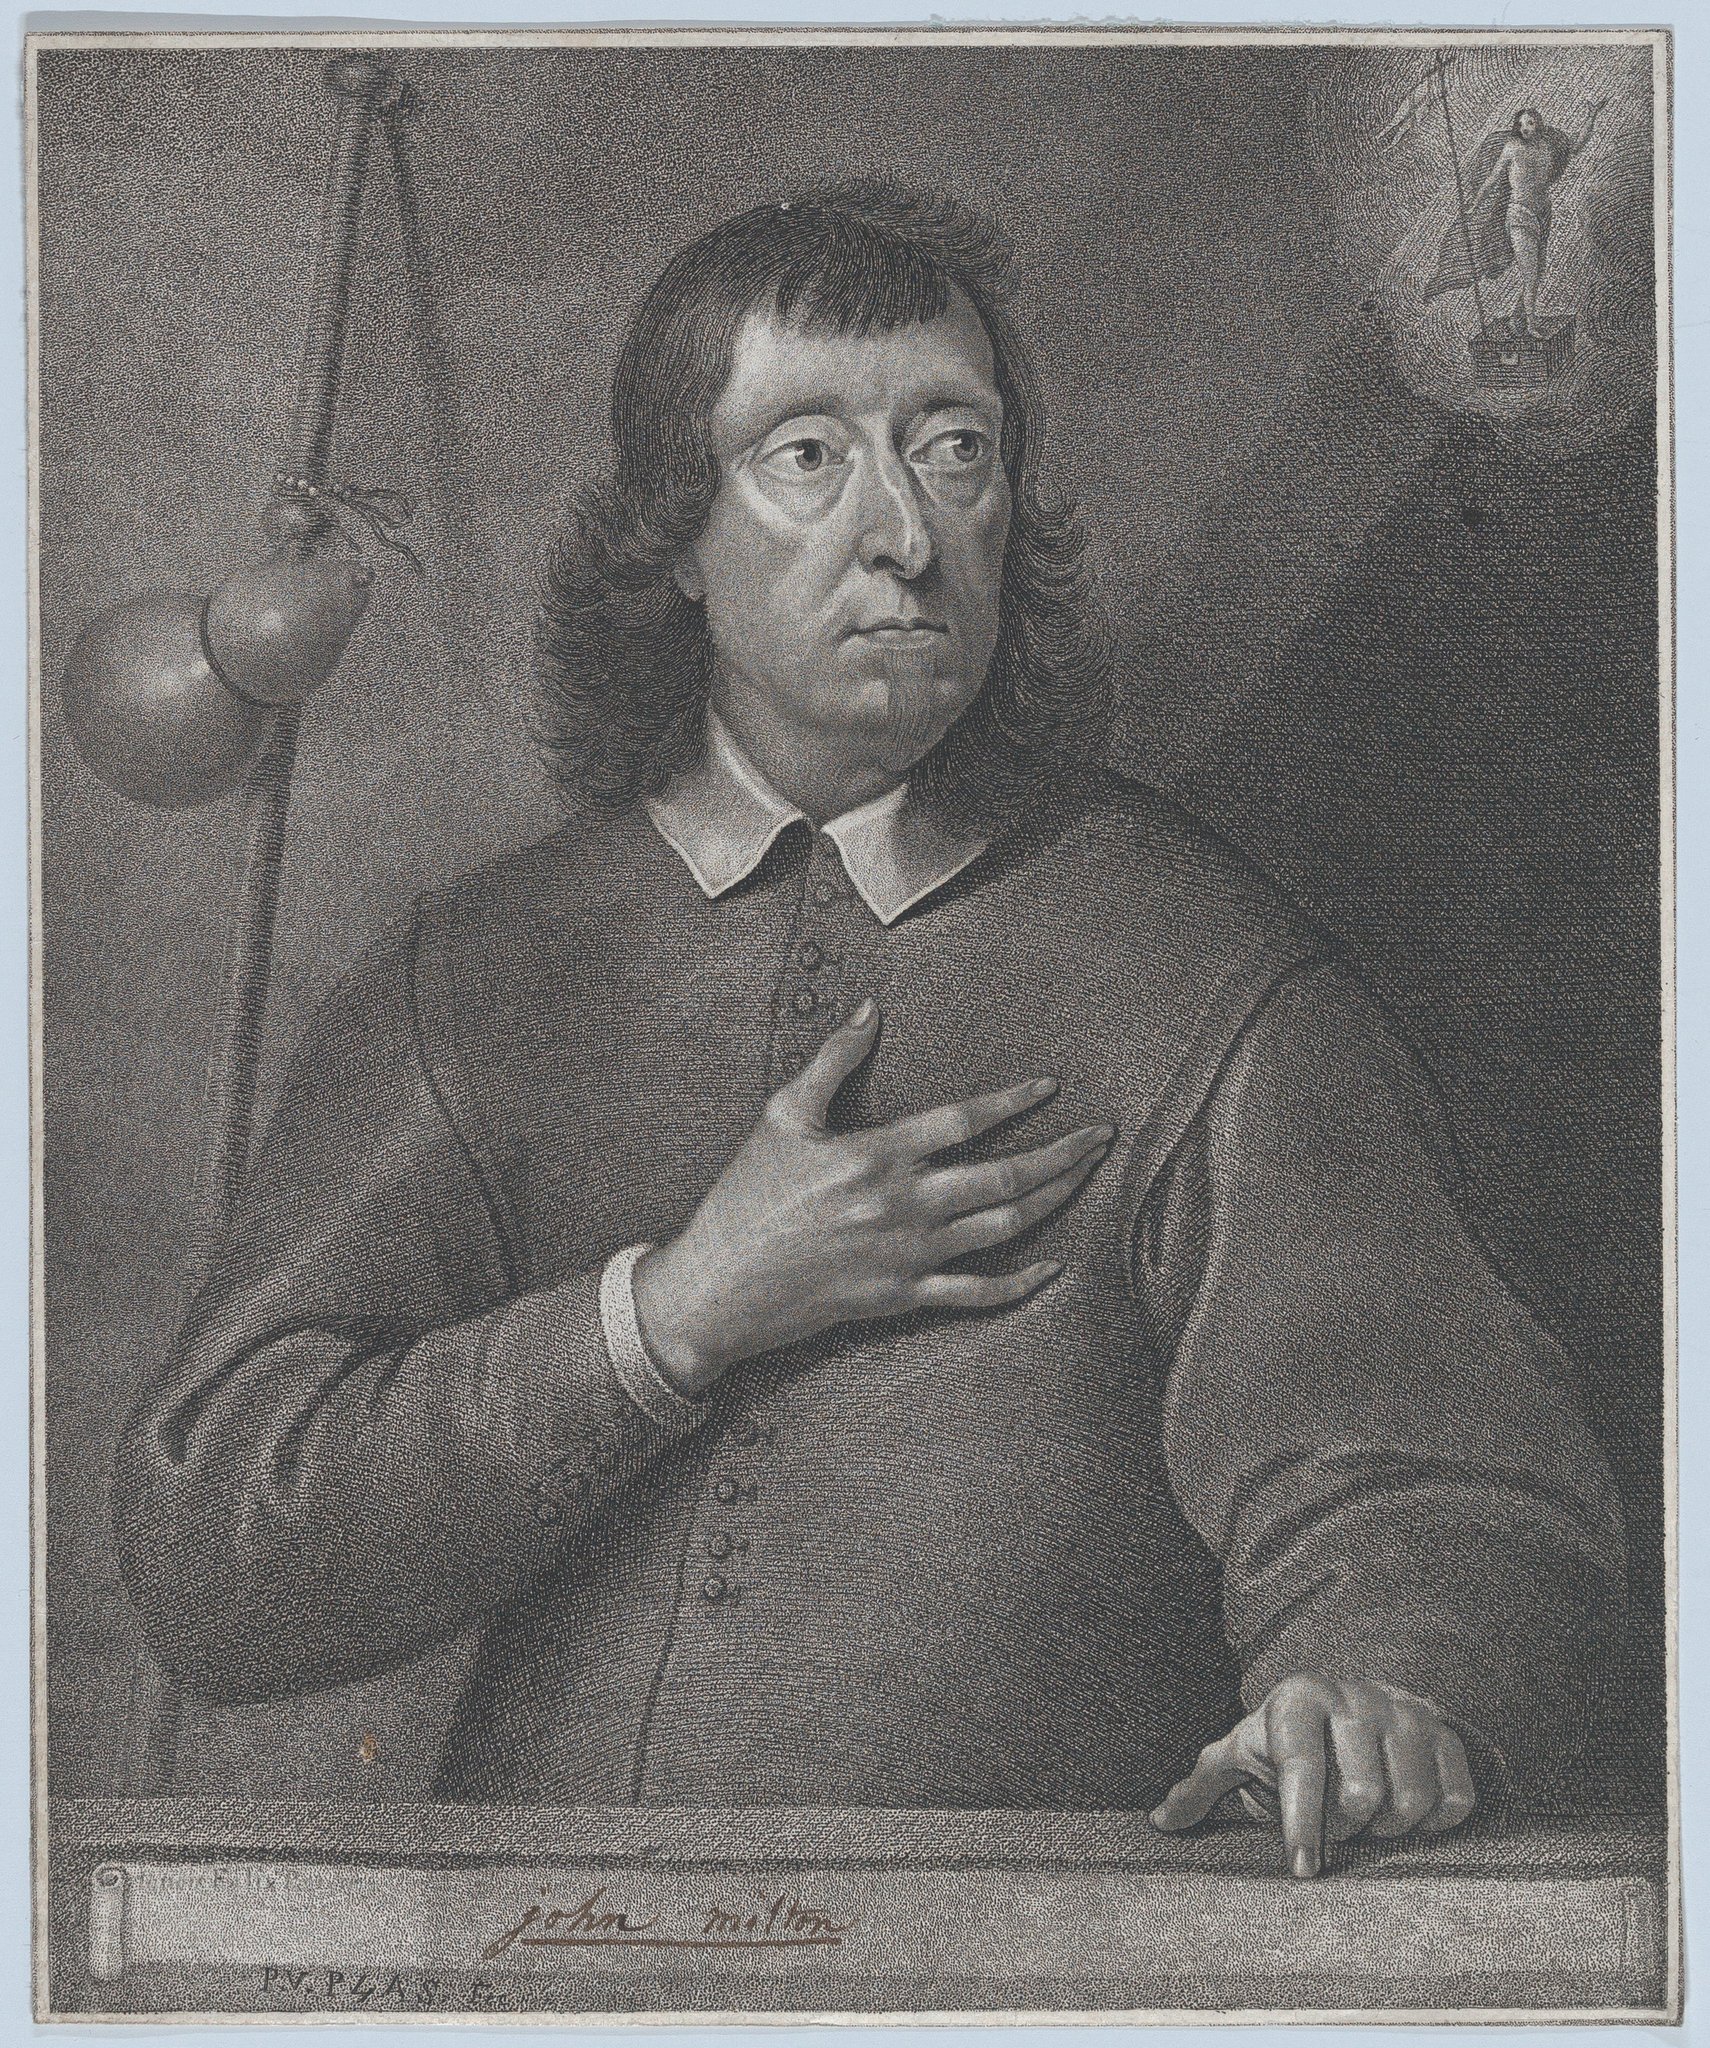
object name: print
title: John Milton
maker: george quinton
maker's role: engraver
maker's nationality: british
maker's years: 1750-1800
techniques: engraving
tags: men,portraits,poets